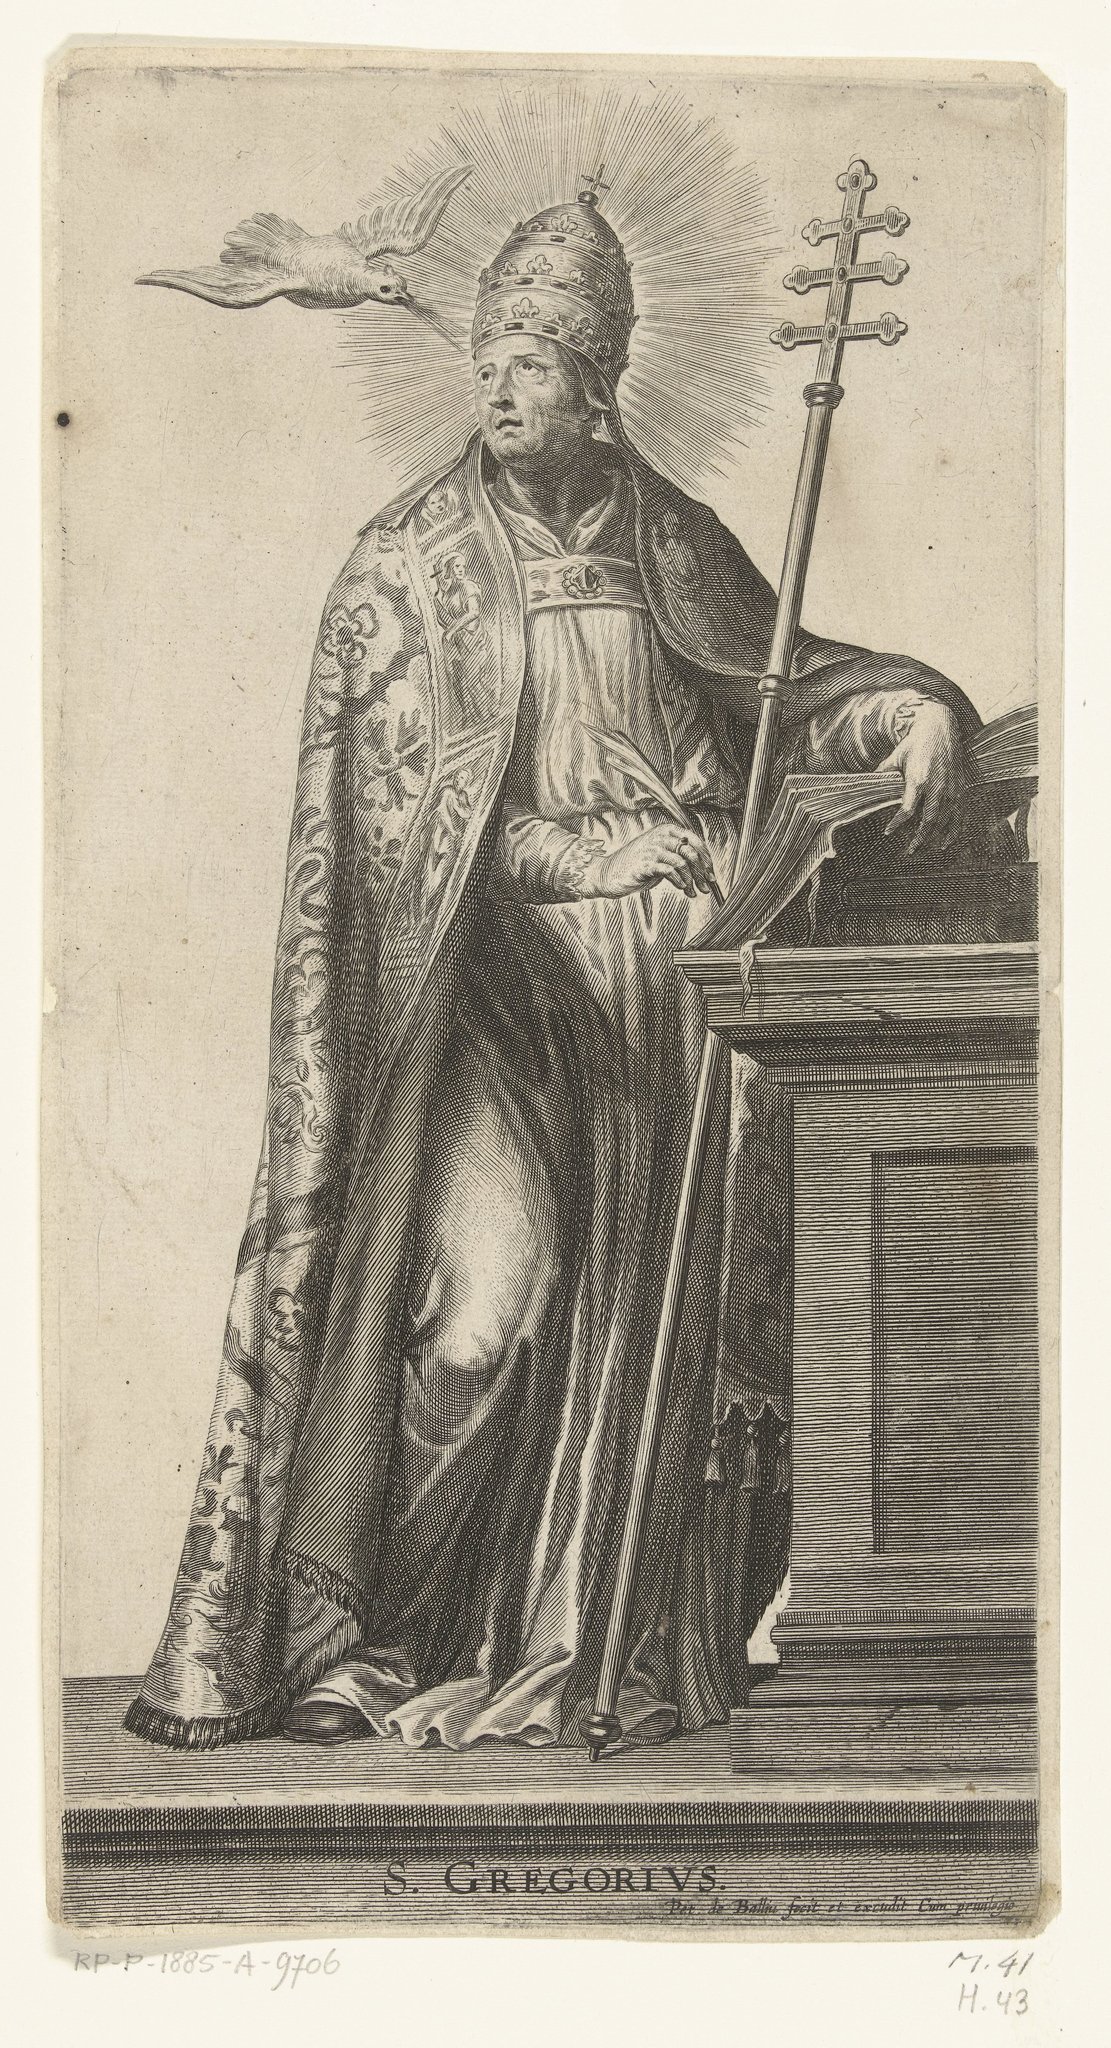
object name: print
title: S. Gregorivs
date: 1623-1660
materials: paper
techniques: engraving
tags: pope gregory the great; possible attributes: dove, emperor trajan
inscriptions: collector's mark: Lugt 2228